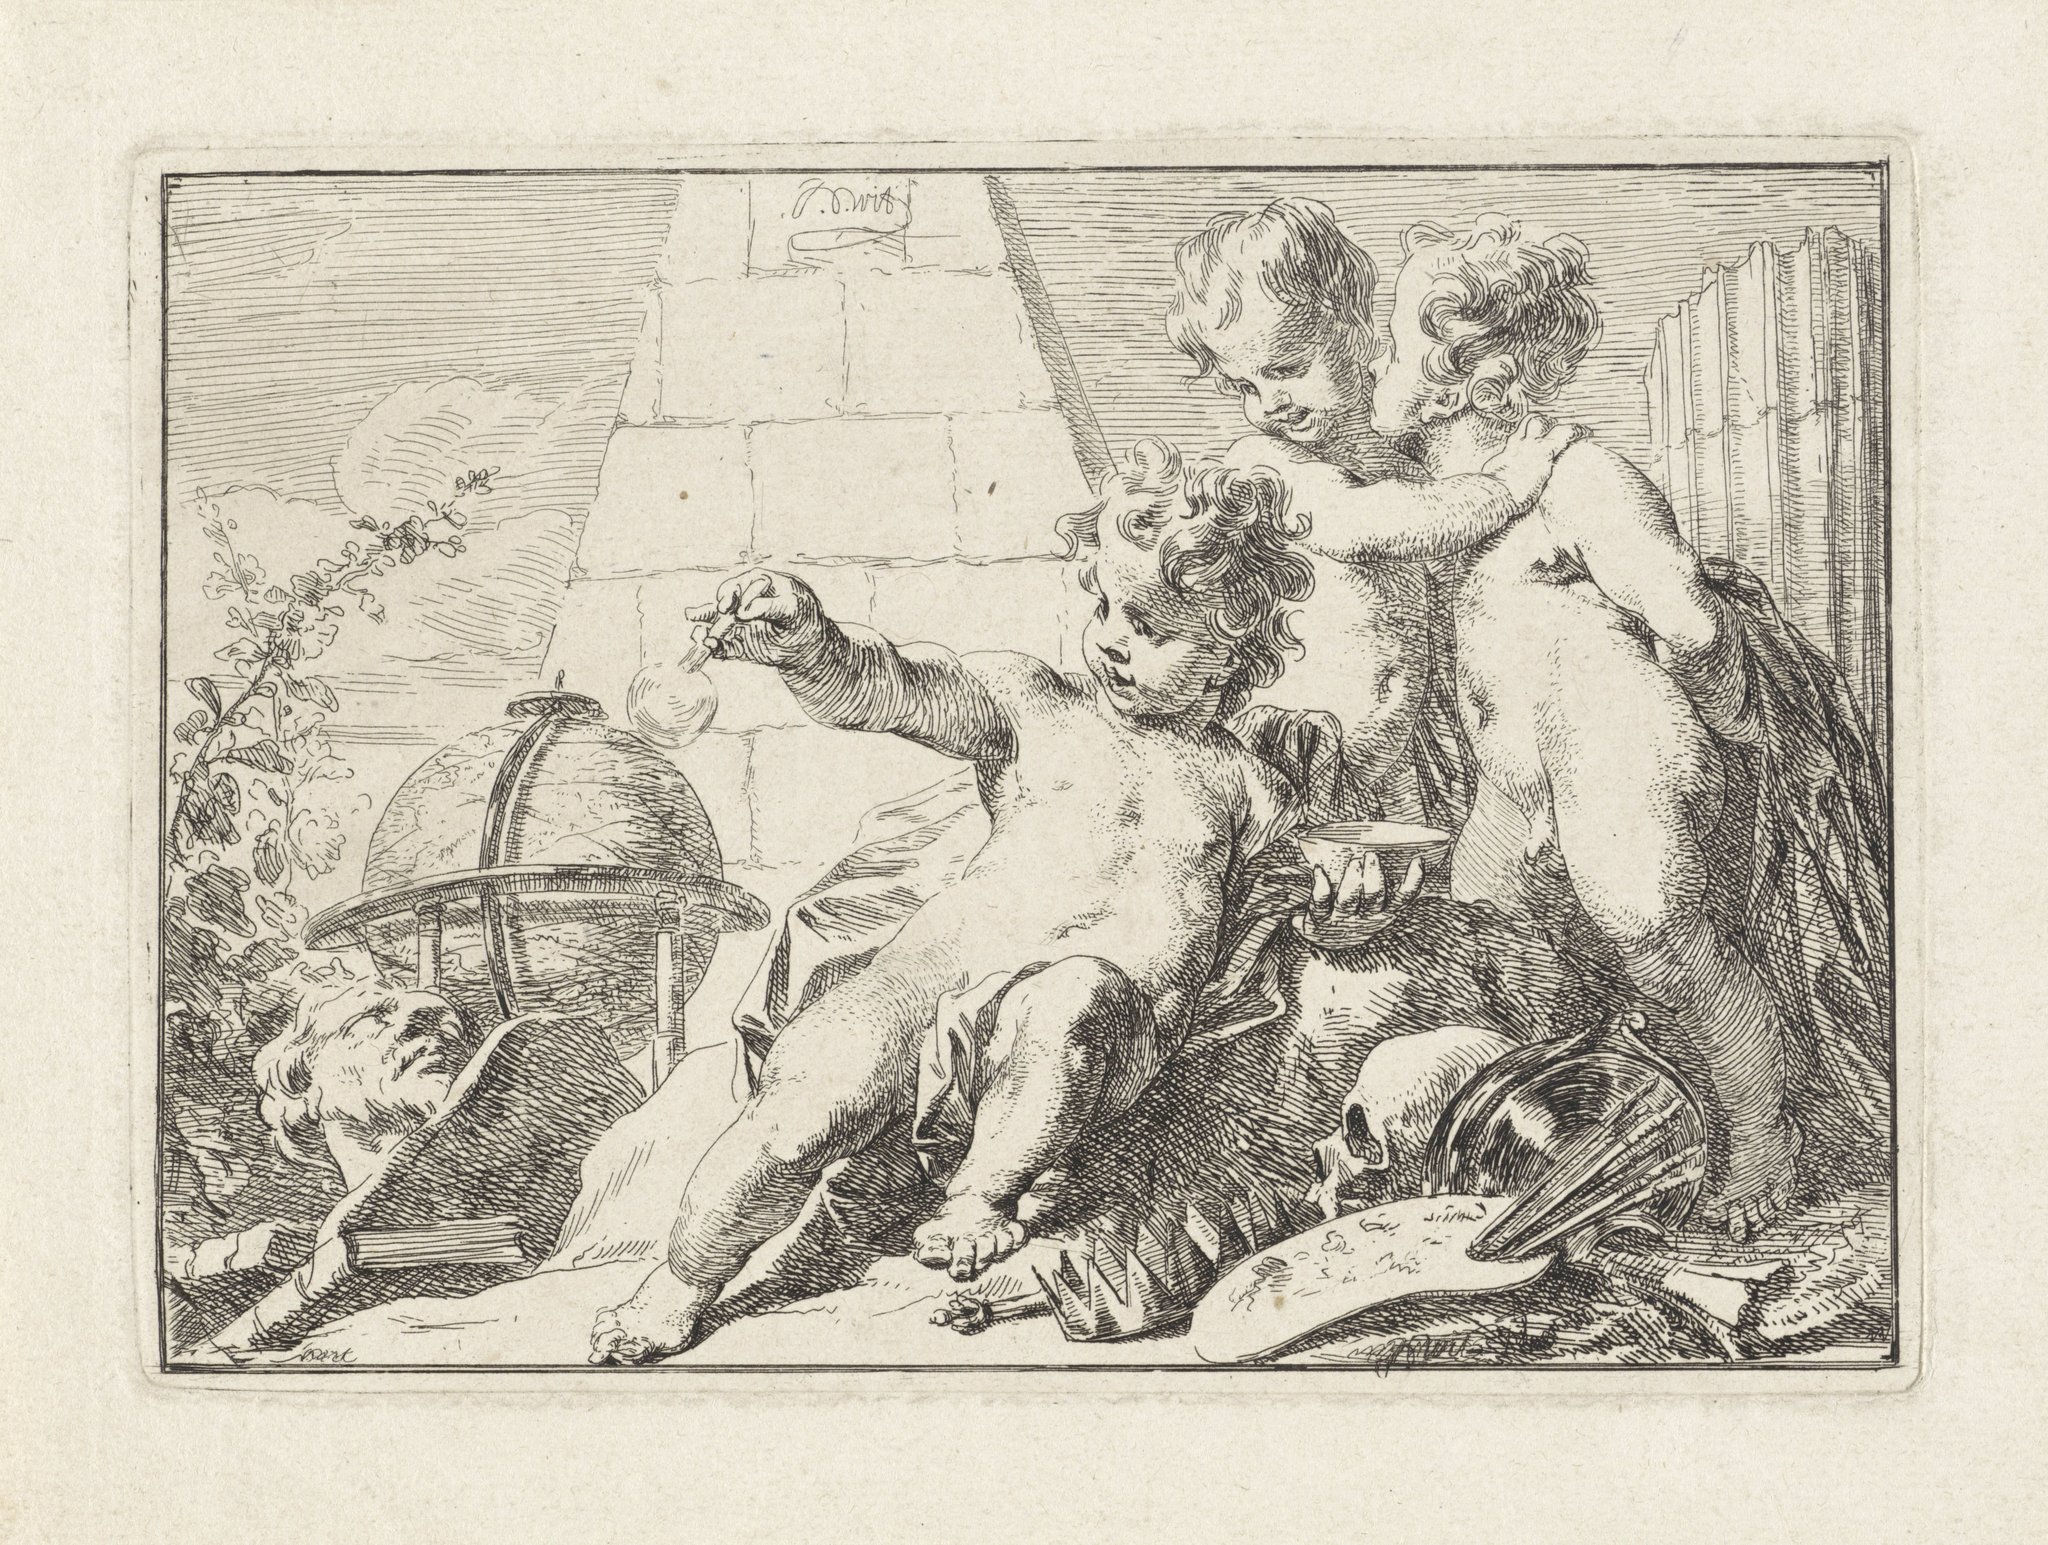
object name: print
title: Allegory of Transience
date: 1705-1754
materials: paper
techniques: etching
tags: cupids: 'amores', 'amoretti', 'putti', mortality, extinction of life, (children or putti) blowing bubbles, 'homo bulla' ~ scene symbolizing 'vanitas'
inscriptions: collector's mark: Lugt 2228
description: Voor een piramide spelen drie naakte putti. Een van hen is aan het bellenblazen. De putti zijn omringd door vergankelijkheidsymbolen zoals globe, de zeepbel, schedel en het antiek gebeeldhouwde hoofd. Deze objecten wijzen op het verstrijken van de tijd. Het boek en het schilderspalet kunnen opgevat worden als dat de kunst de dood overwint.